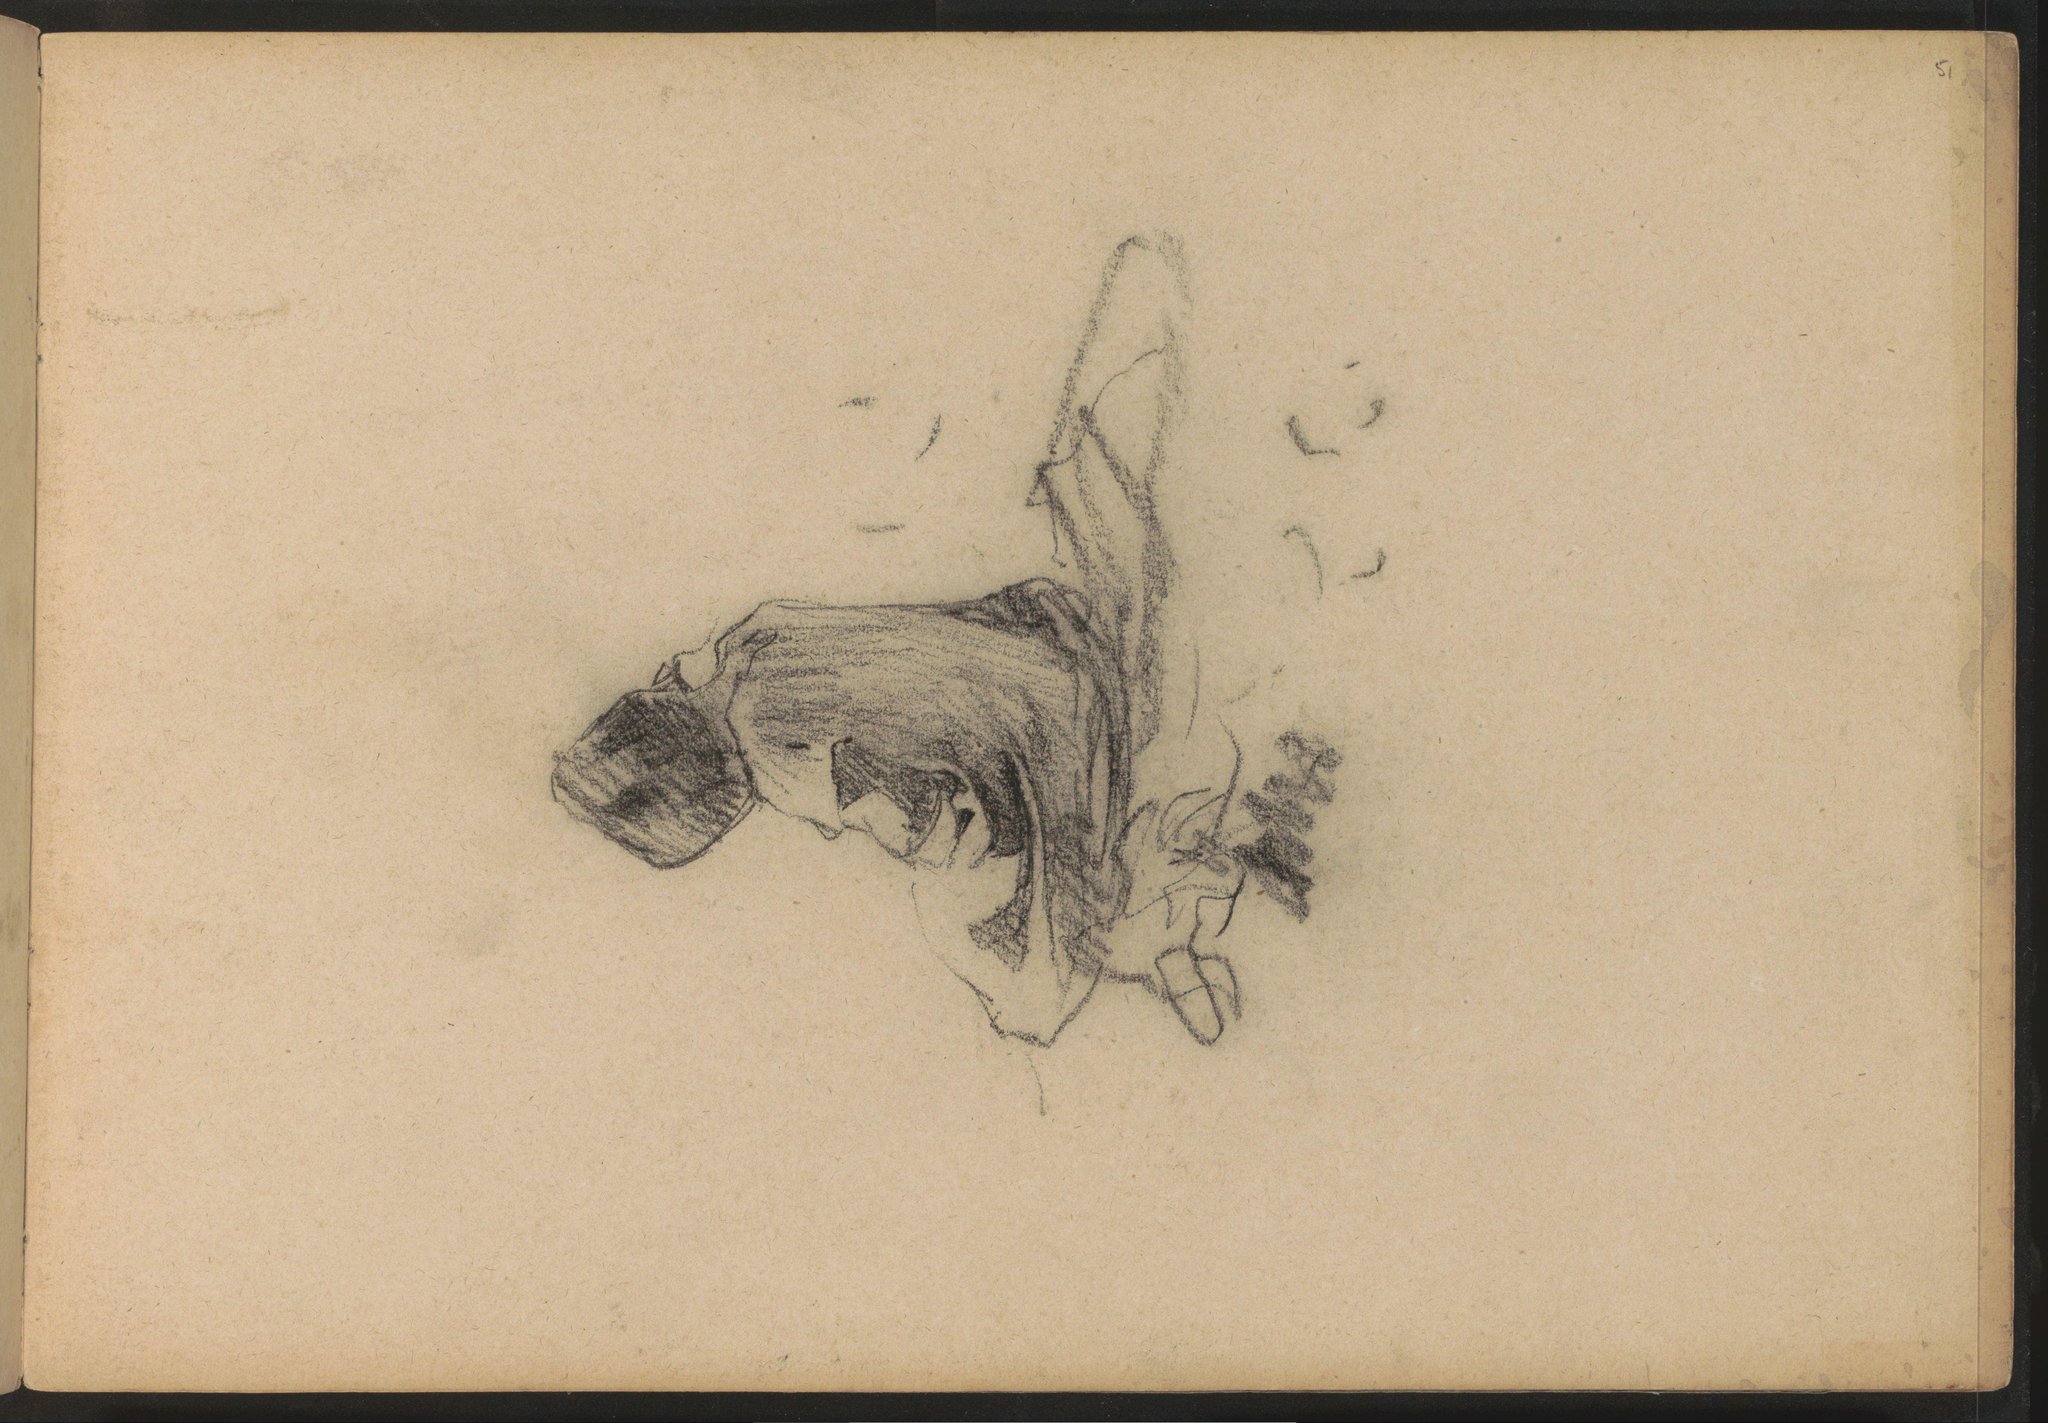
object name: sketchbook leaf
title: Zittend meisje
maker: willem witsen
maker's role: draughtsman, painter, print maker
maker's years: 1860-1923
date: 1884-1887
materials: chalk, paper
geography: ewijkshoeve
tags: girl (child between toddler and youth) (+ sitting)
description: Pagina 51 uit een schetsboek met 29 bladen.